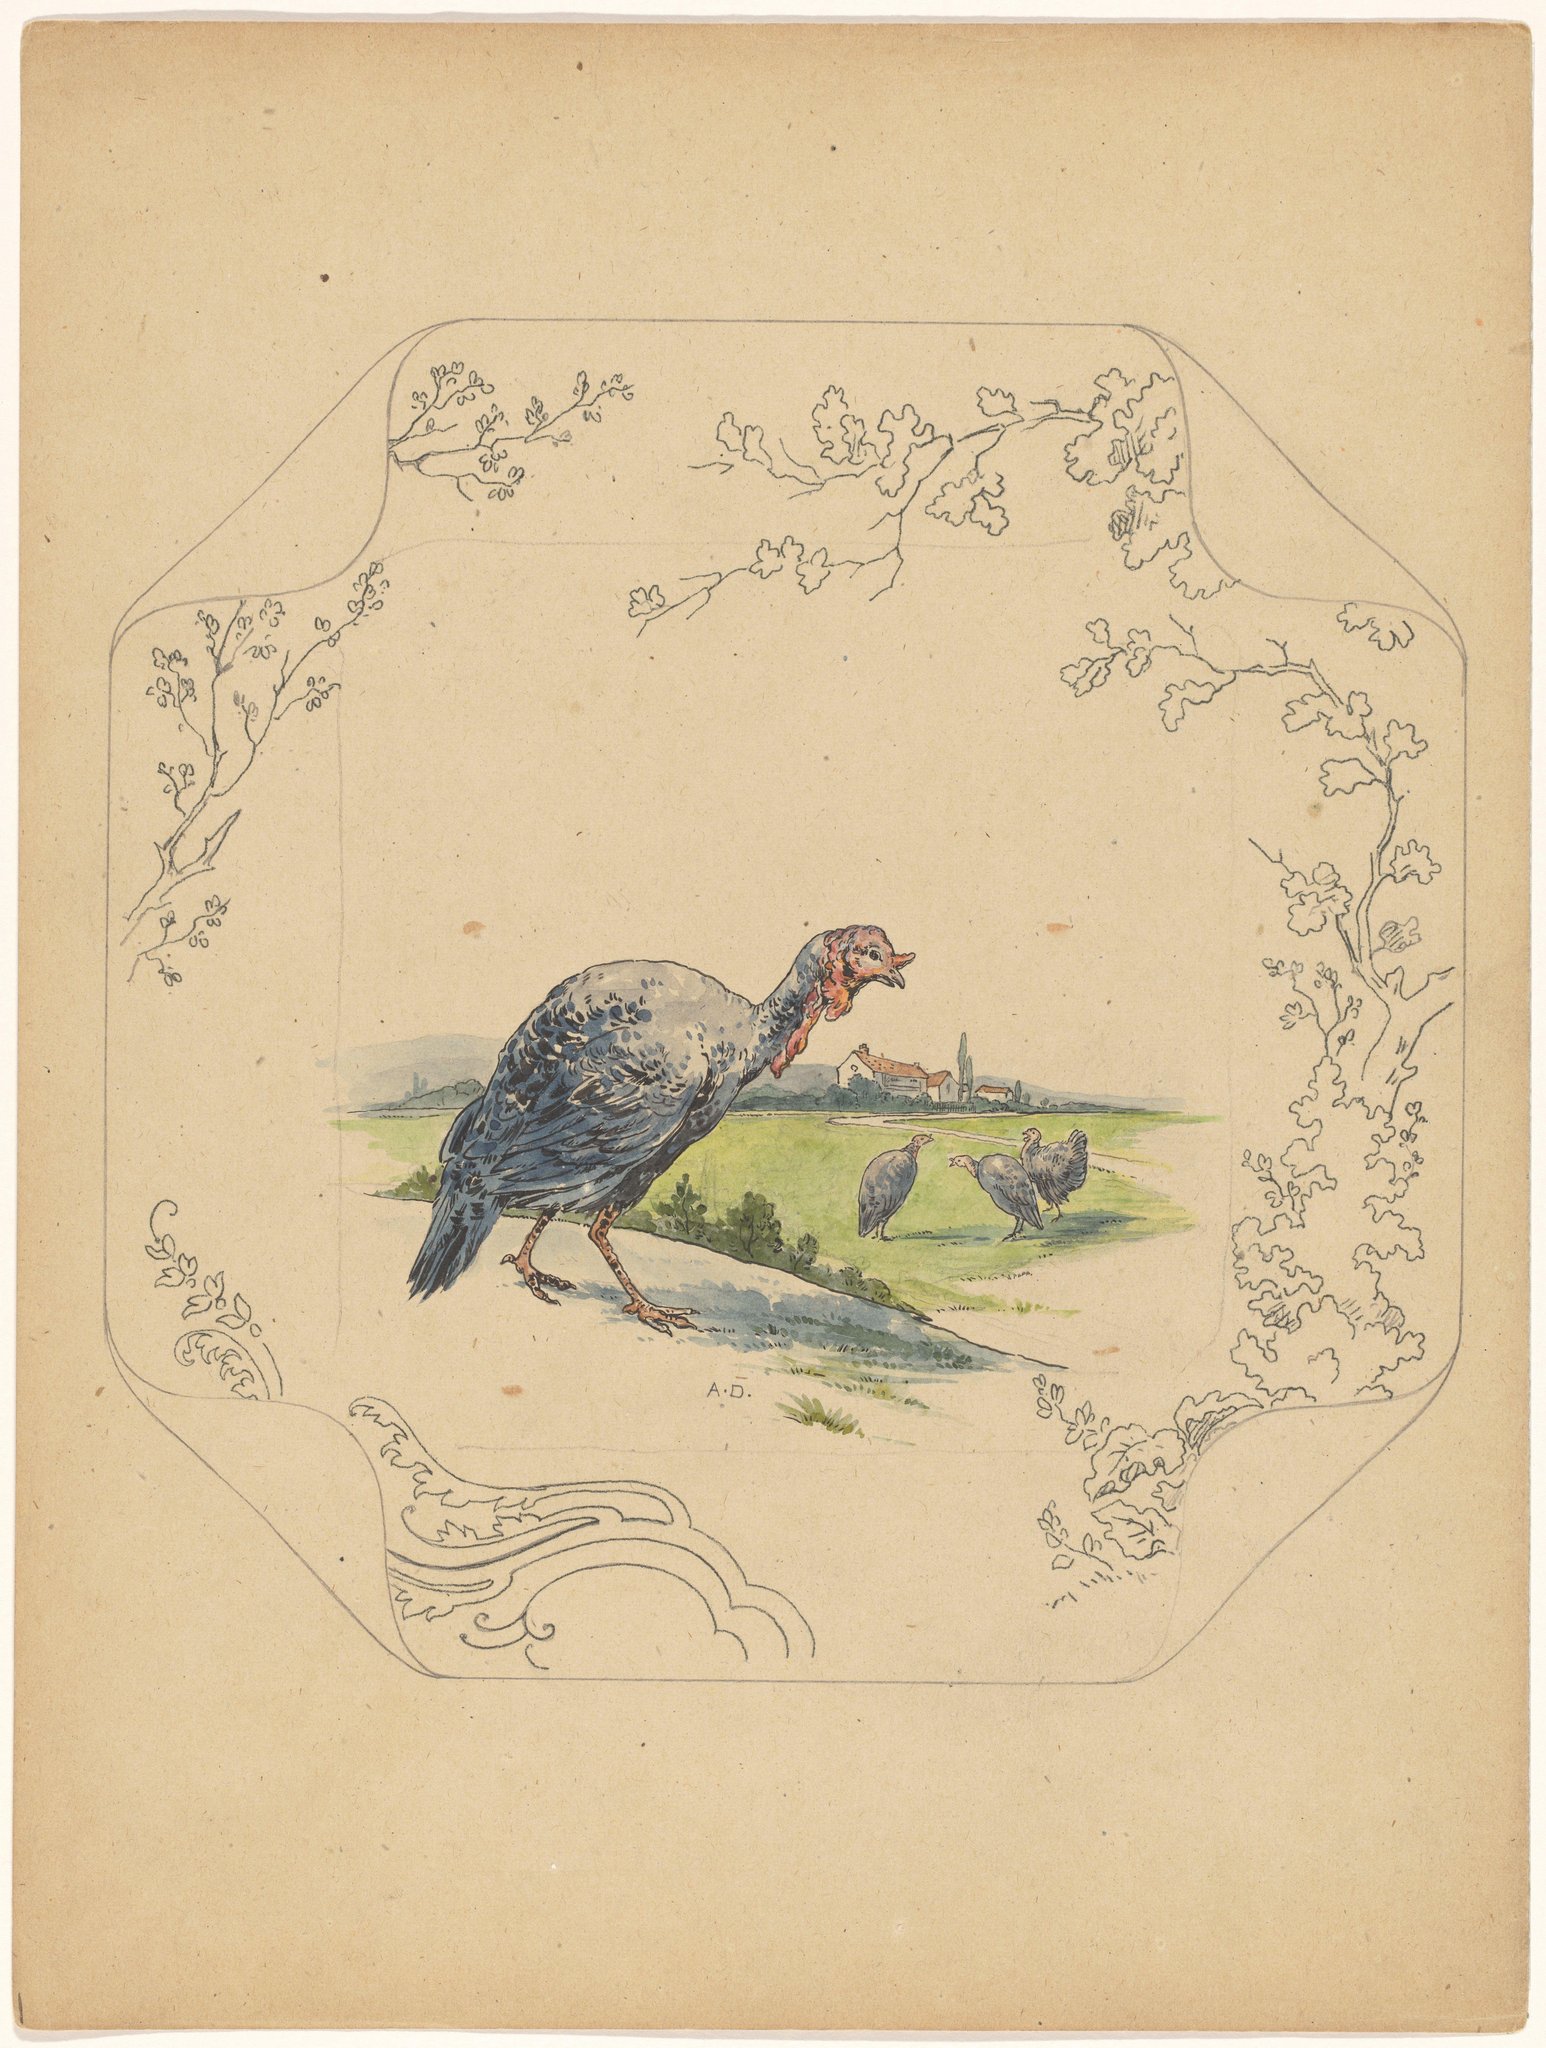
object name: drawing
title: Negen ontwerpen voor borden van het model 'Square' door Albert Dammouse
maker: albert louis dammouse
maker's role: ceramicist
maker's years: 1848-1926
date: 1875-1880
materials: graphite, ink, paper, watercolor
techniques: brush, pen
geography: sèvres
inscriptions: monogram: ‘A.D.’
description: Het plat gedecoreerd met een kalkoen met drie jongen, enkele huizen op de achtergrond.